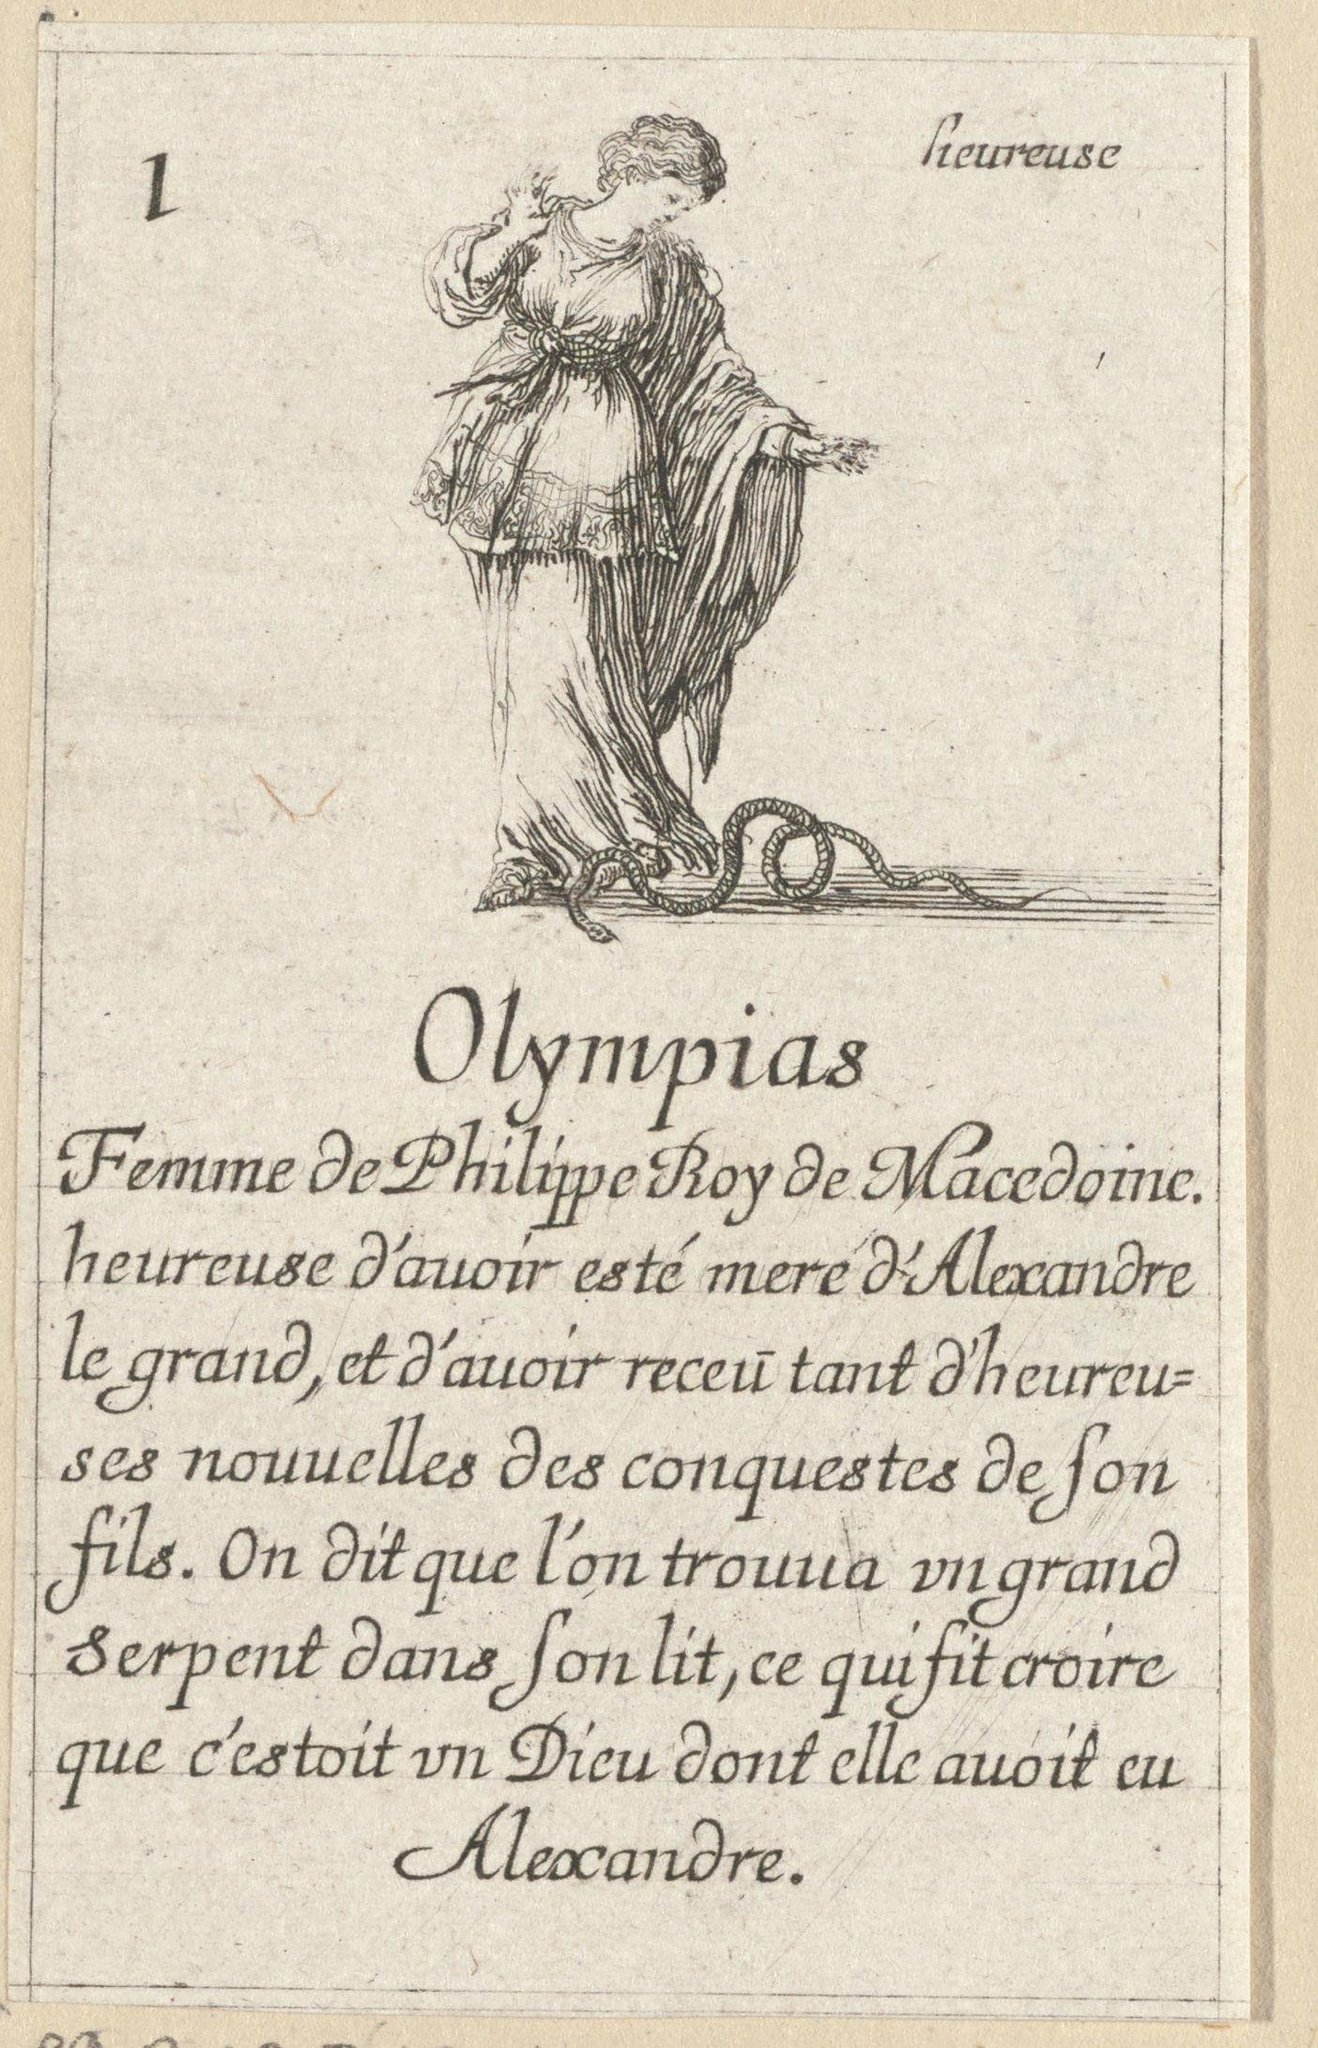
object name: print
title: Jeu des reynes renommées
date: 1620-1664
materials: paper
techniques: etching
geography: paris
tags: ruler, sovereign - bb - female ruler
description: Deze prent maakt deel uit van een kaartspel met 52 kaarten met voorstellingen van beroemde koninginnen. De serie is uitgedacht door Jean Desmarests de Saint-Sorlin in opdracht van Kardinaal Mazarin. Het kaartspel werd gemaakt voor de jonge Lodewijk XIV, samen met het Jeu des Fables, Jeu de la Géographie en Jeu des Rois de France.